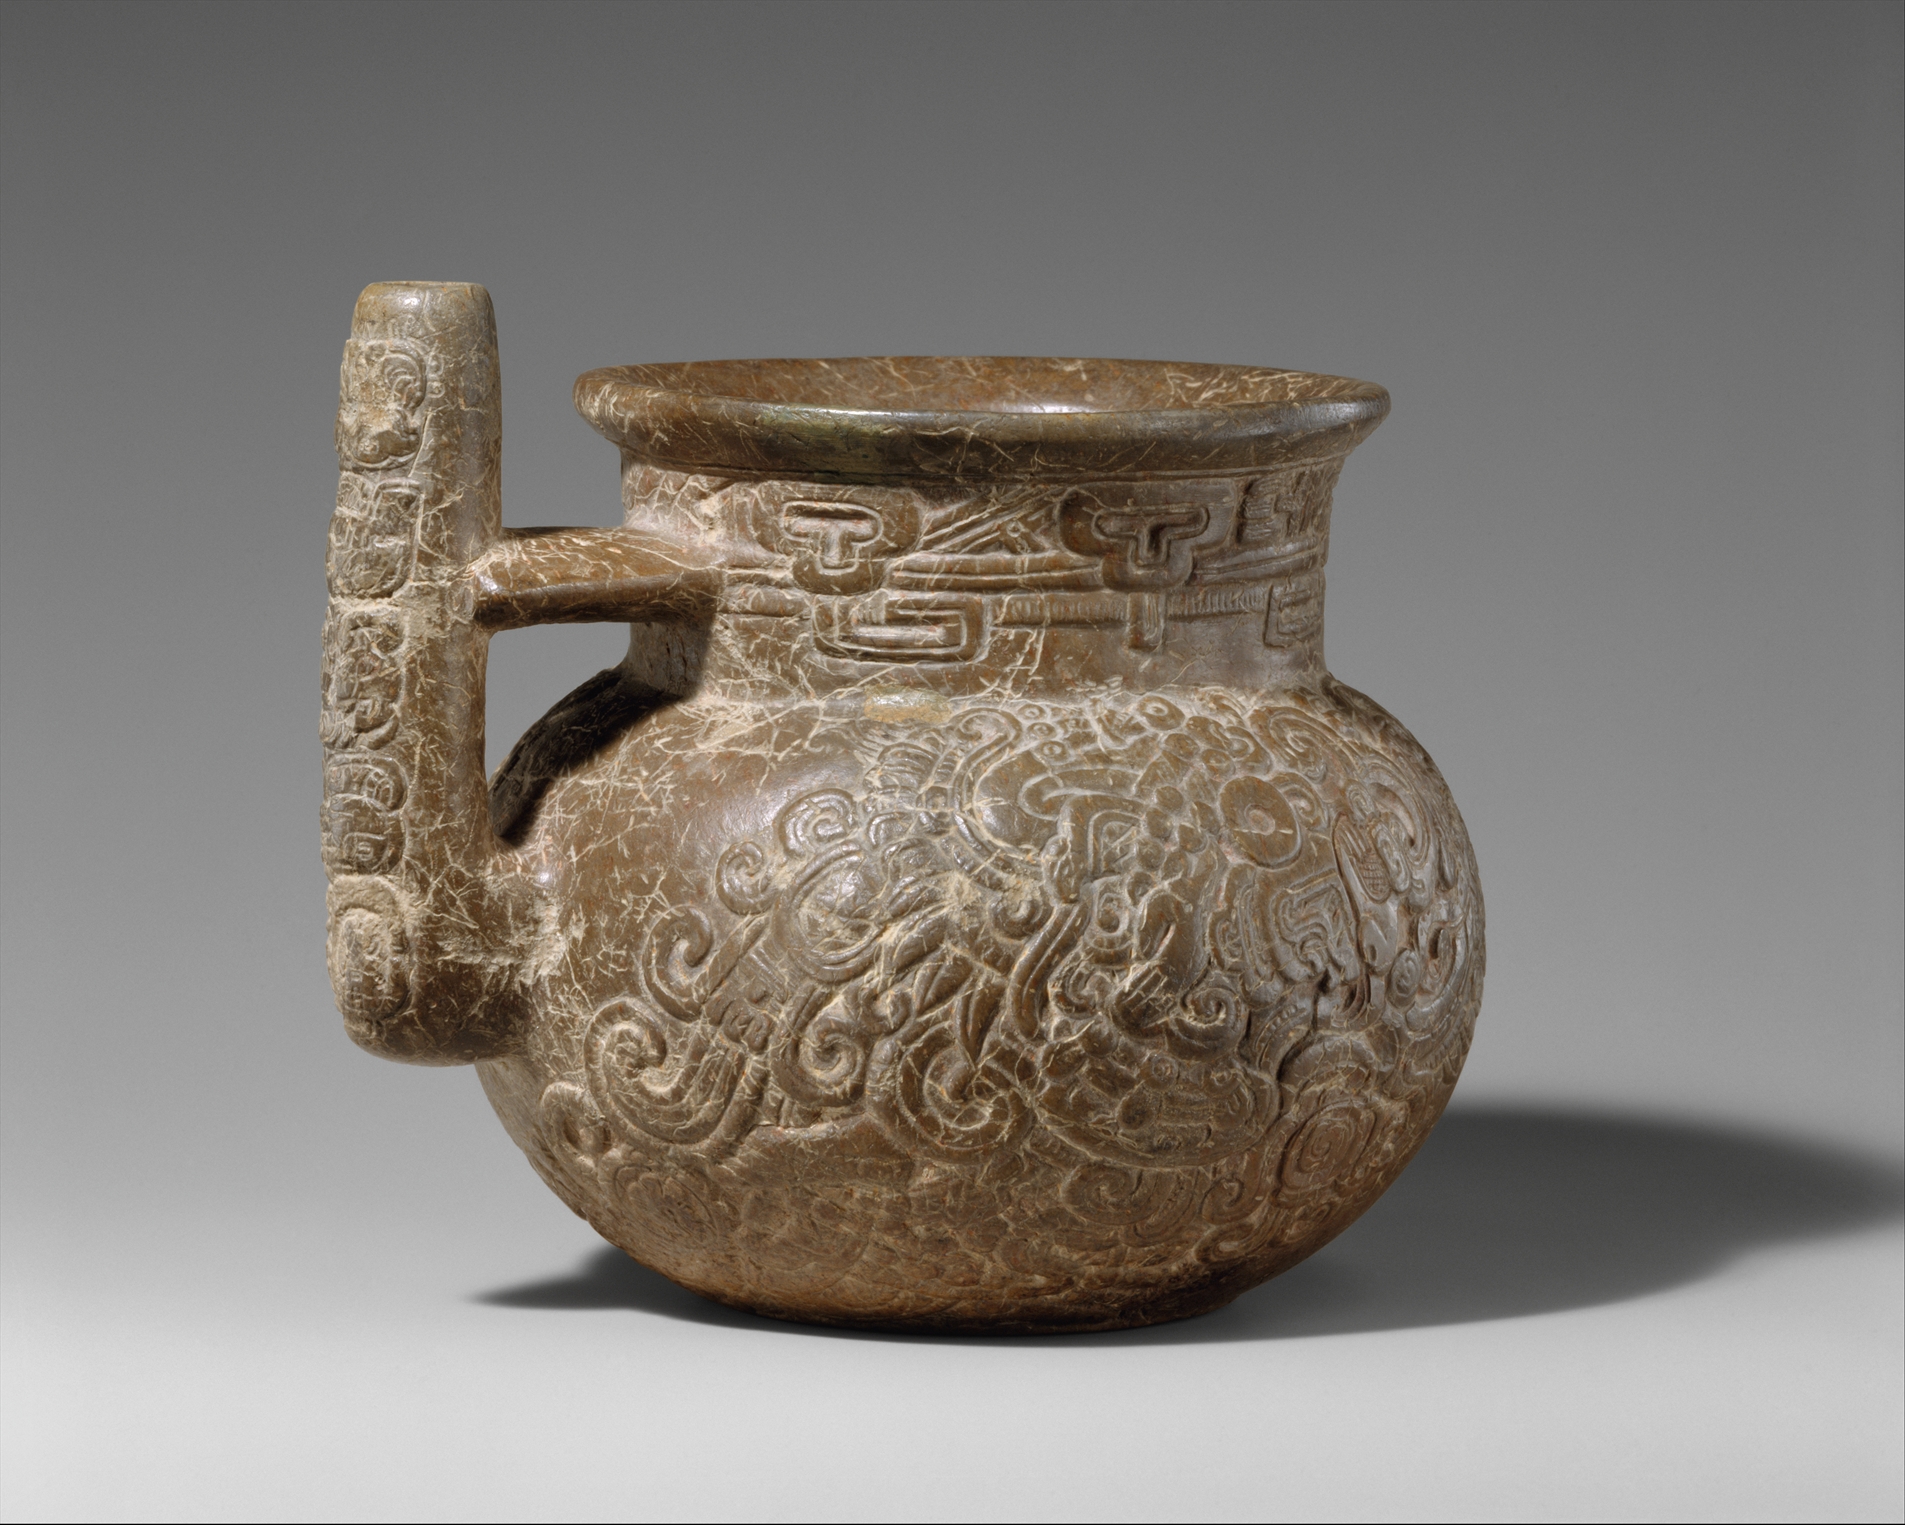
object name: jar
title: Engraved spouted jar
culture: maya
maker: maya artist(s)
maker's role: artist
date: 50 BCE-100 CE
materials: limestone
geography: guatemala or mexico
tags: hieroglyphs